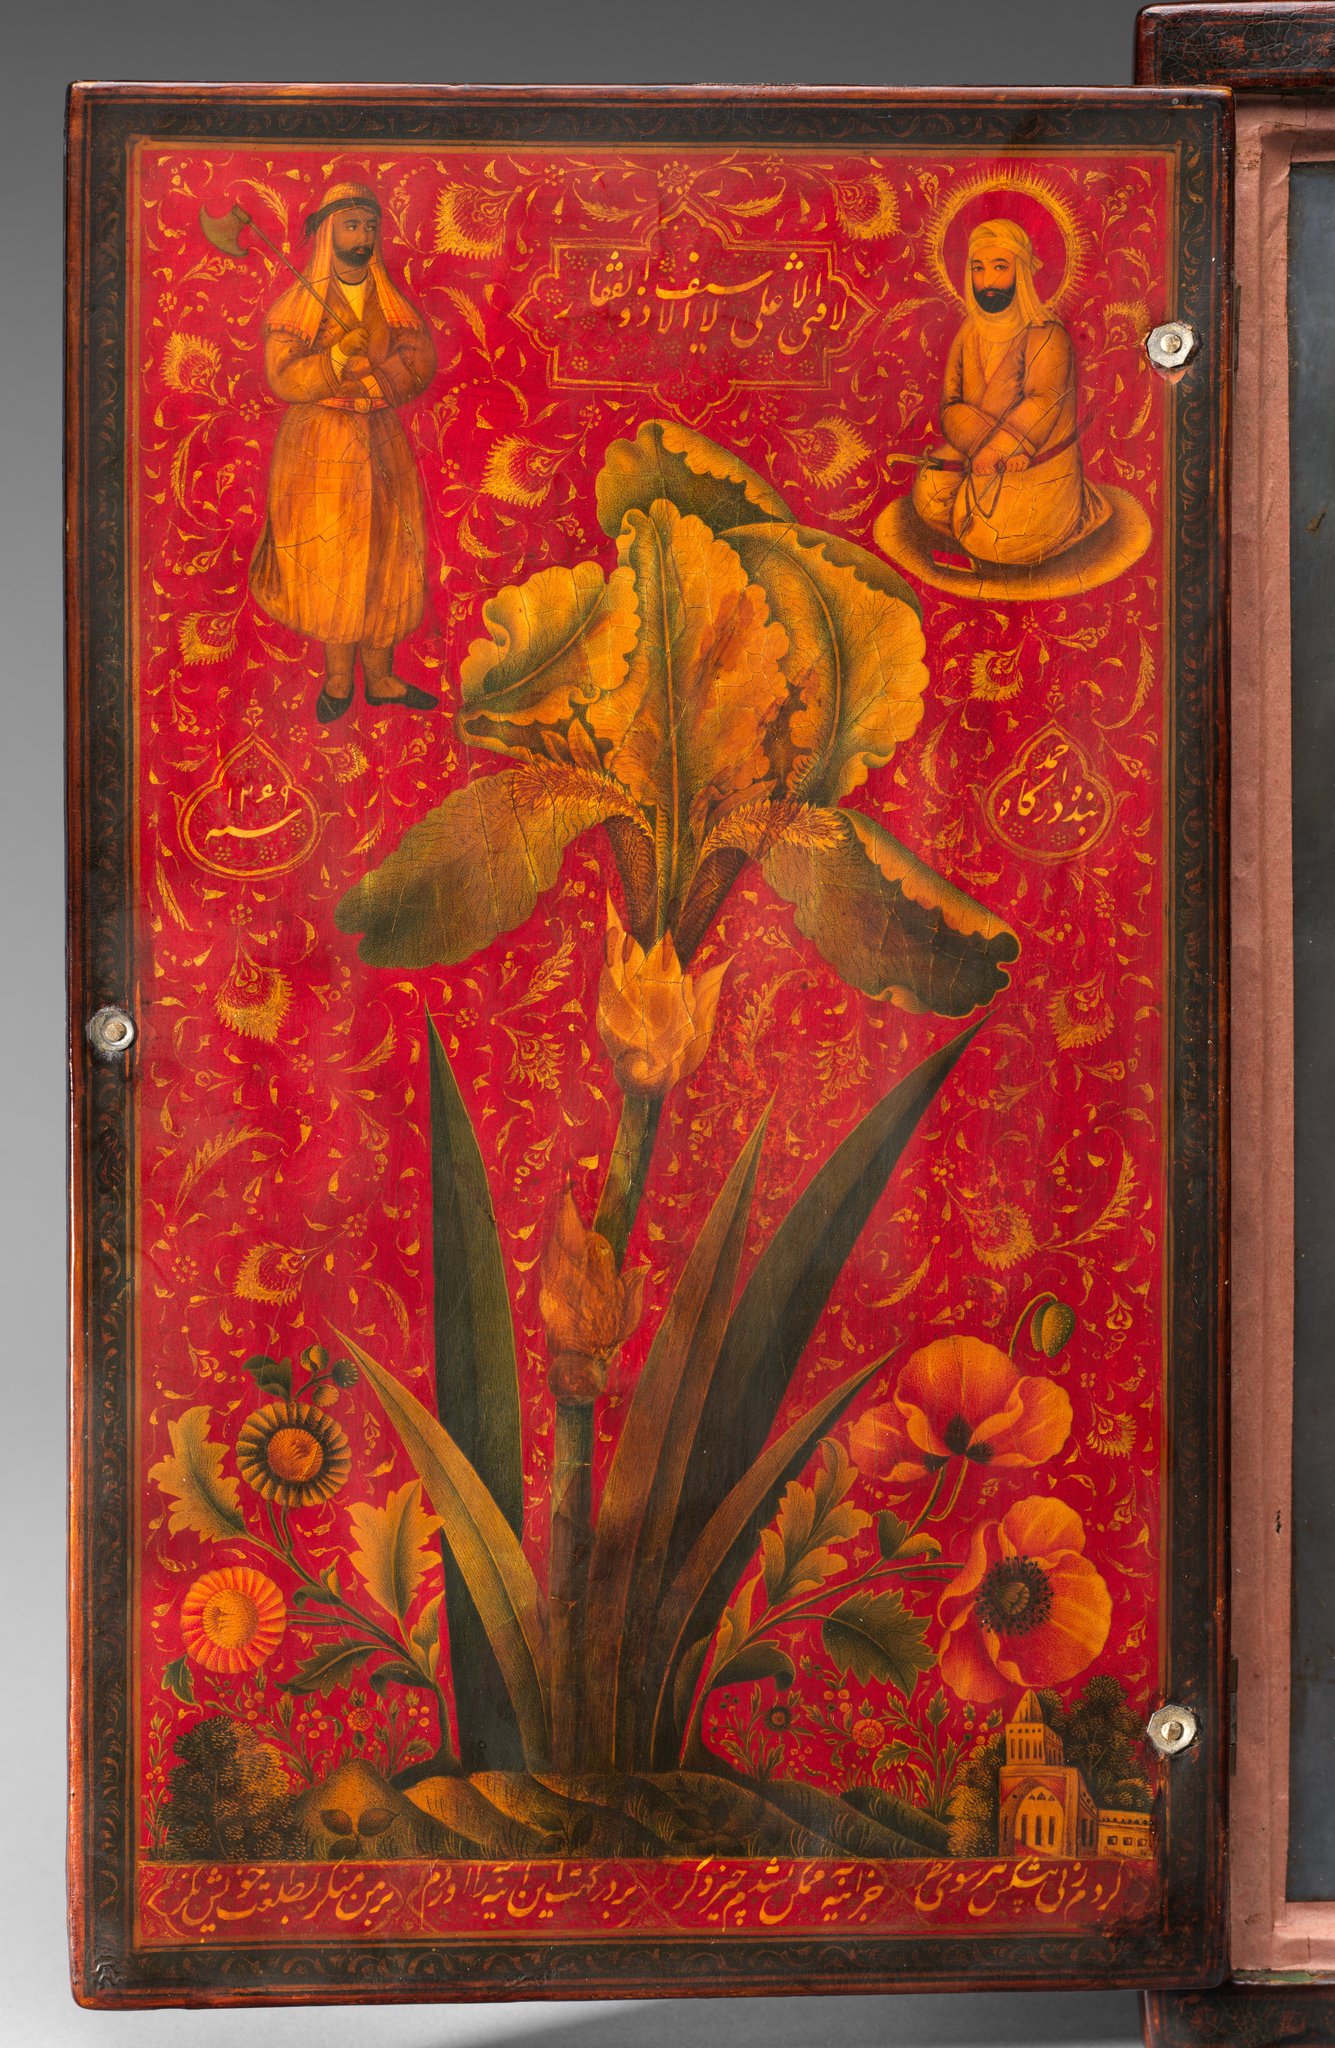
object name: mirror case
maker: aqa ahmad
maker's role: artist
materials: paper, board, watercolor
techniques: gilding, lacquer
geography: iran